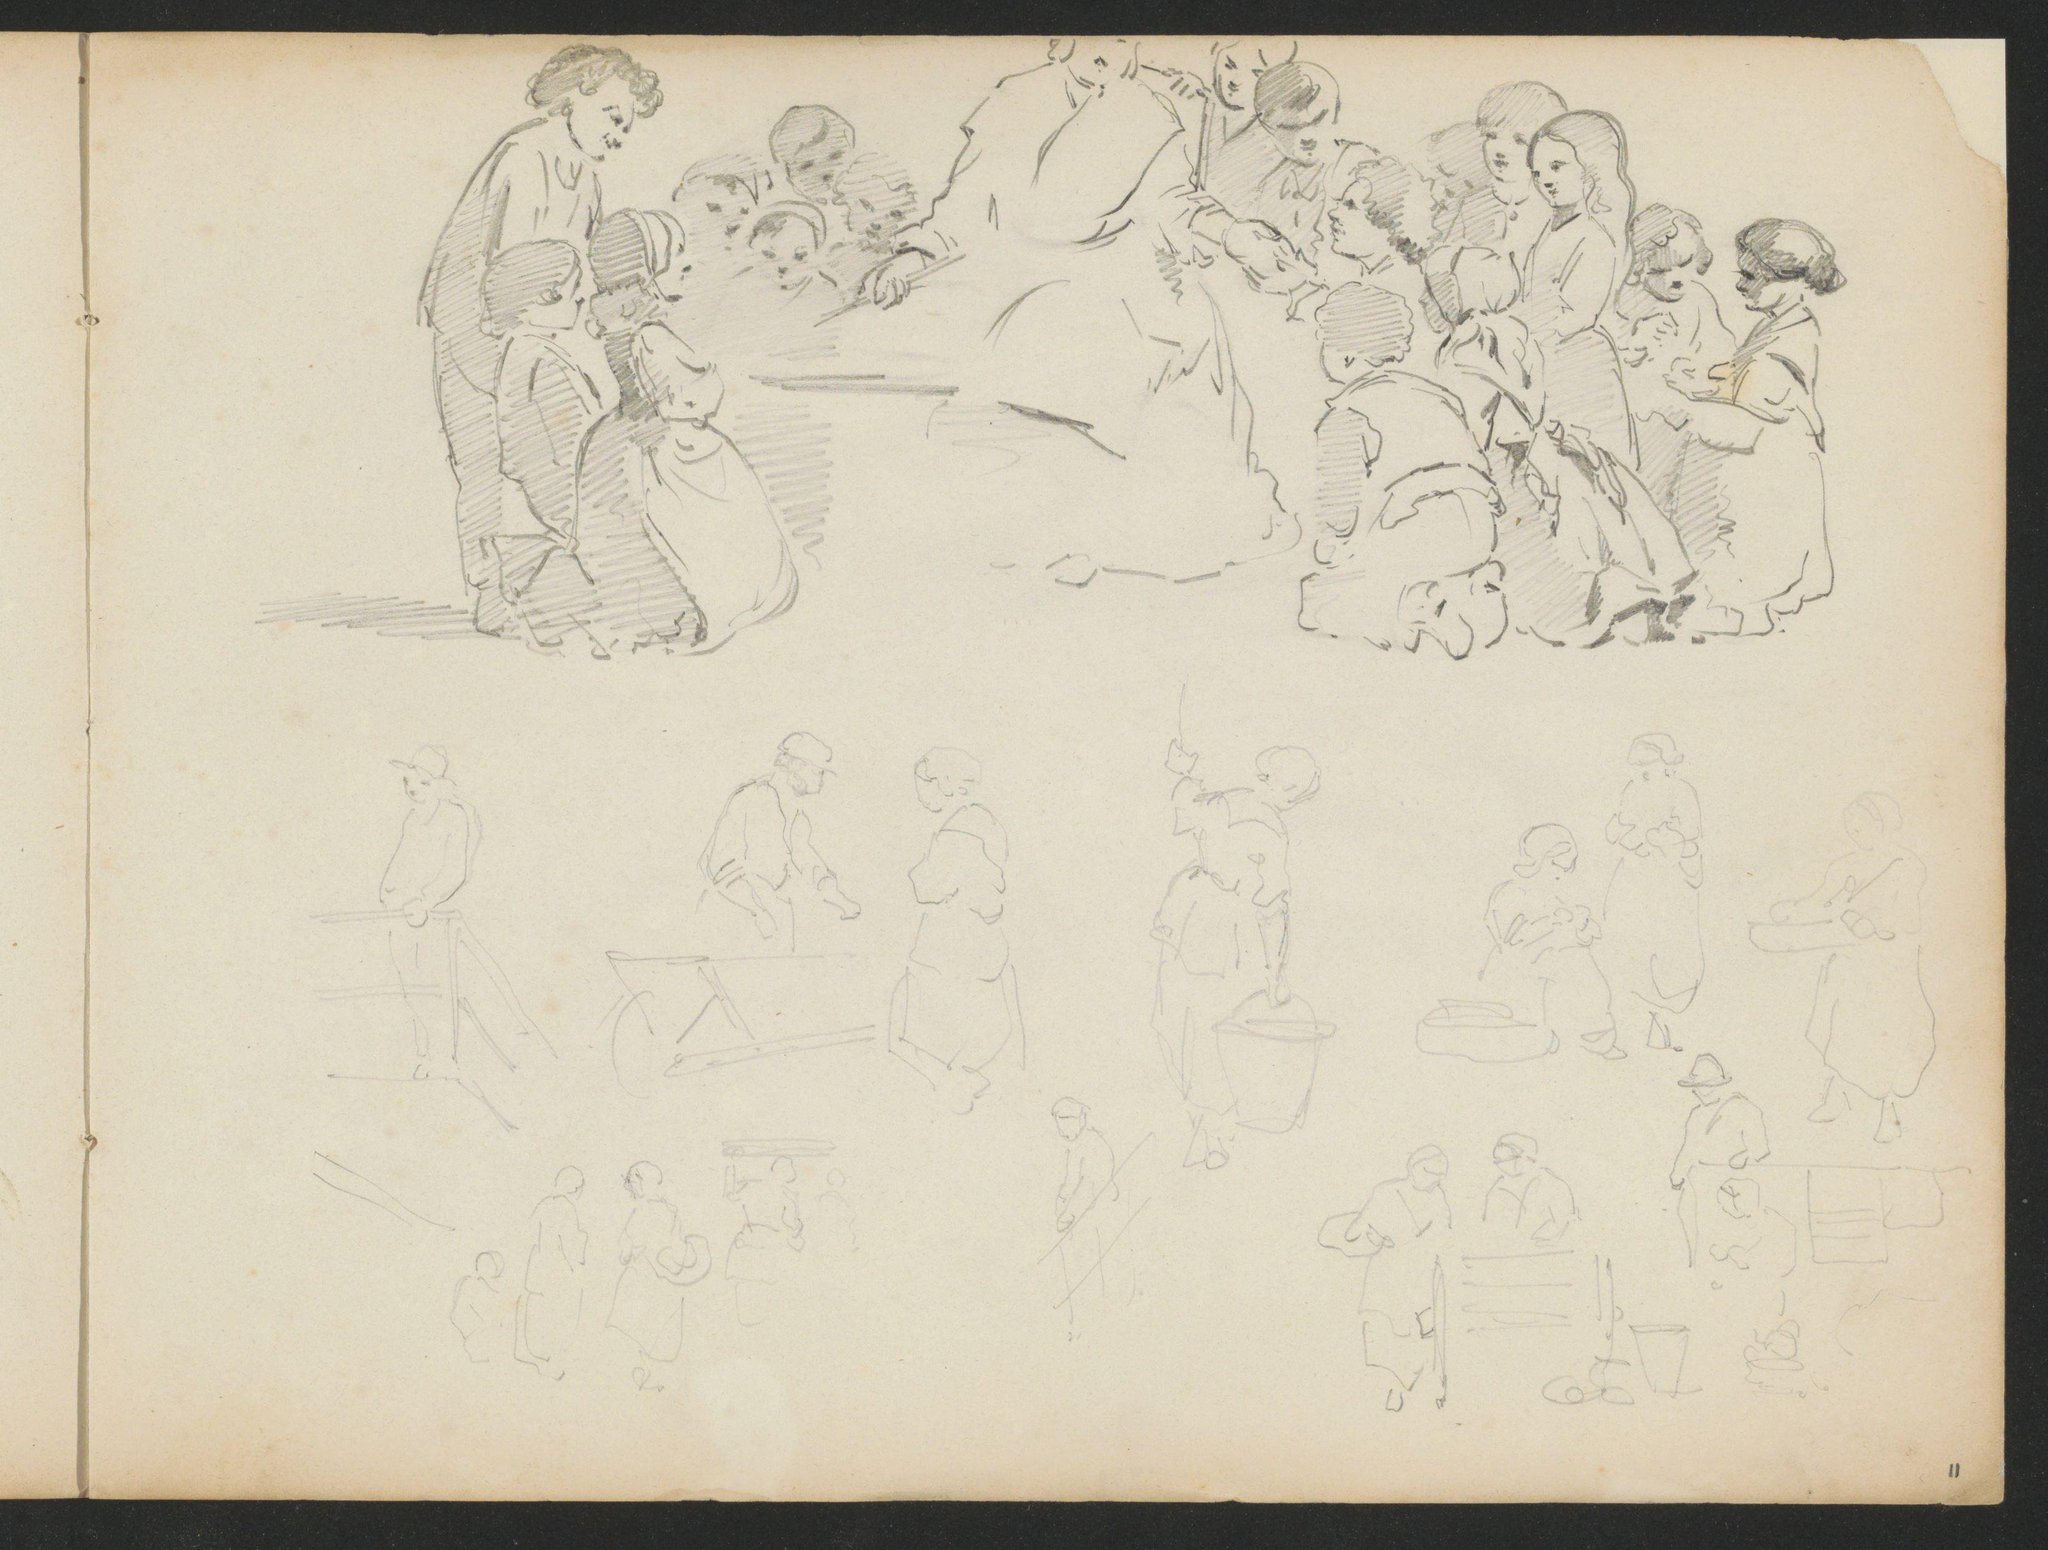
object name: sketchbook leaf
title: Figuurstudies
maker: adrianus eversen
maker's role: draughtsman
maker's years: 1818-1897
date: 1828-1897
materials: paper, pencil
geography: netherlands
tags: christ blessing children brought by their mothers, usually with some disciples disapprovingly looking on (matthew 19:13-15; mark 10:13-16; luke 18:15-17), adult woman, adult man, child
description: Mannen, vrouwen en kinderen in verschillende houdingen en met verschillende bezigheden. Boven kinderen rond een zittende man, mogelijk Christus die de kinderen zegent. Blad 11 uit een schetsboek met 11 bladen.